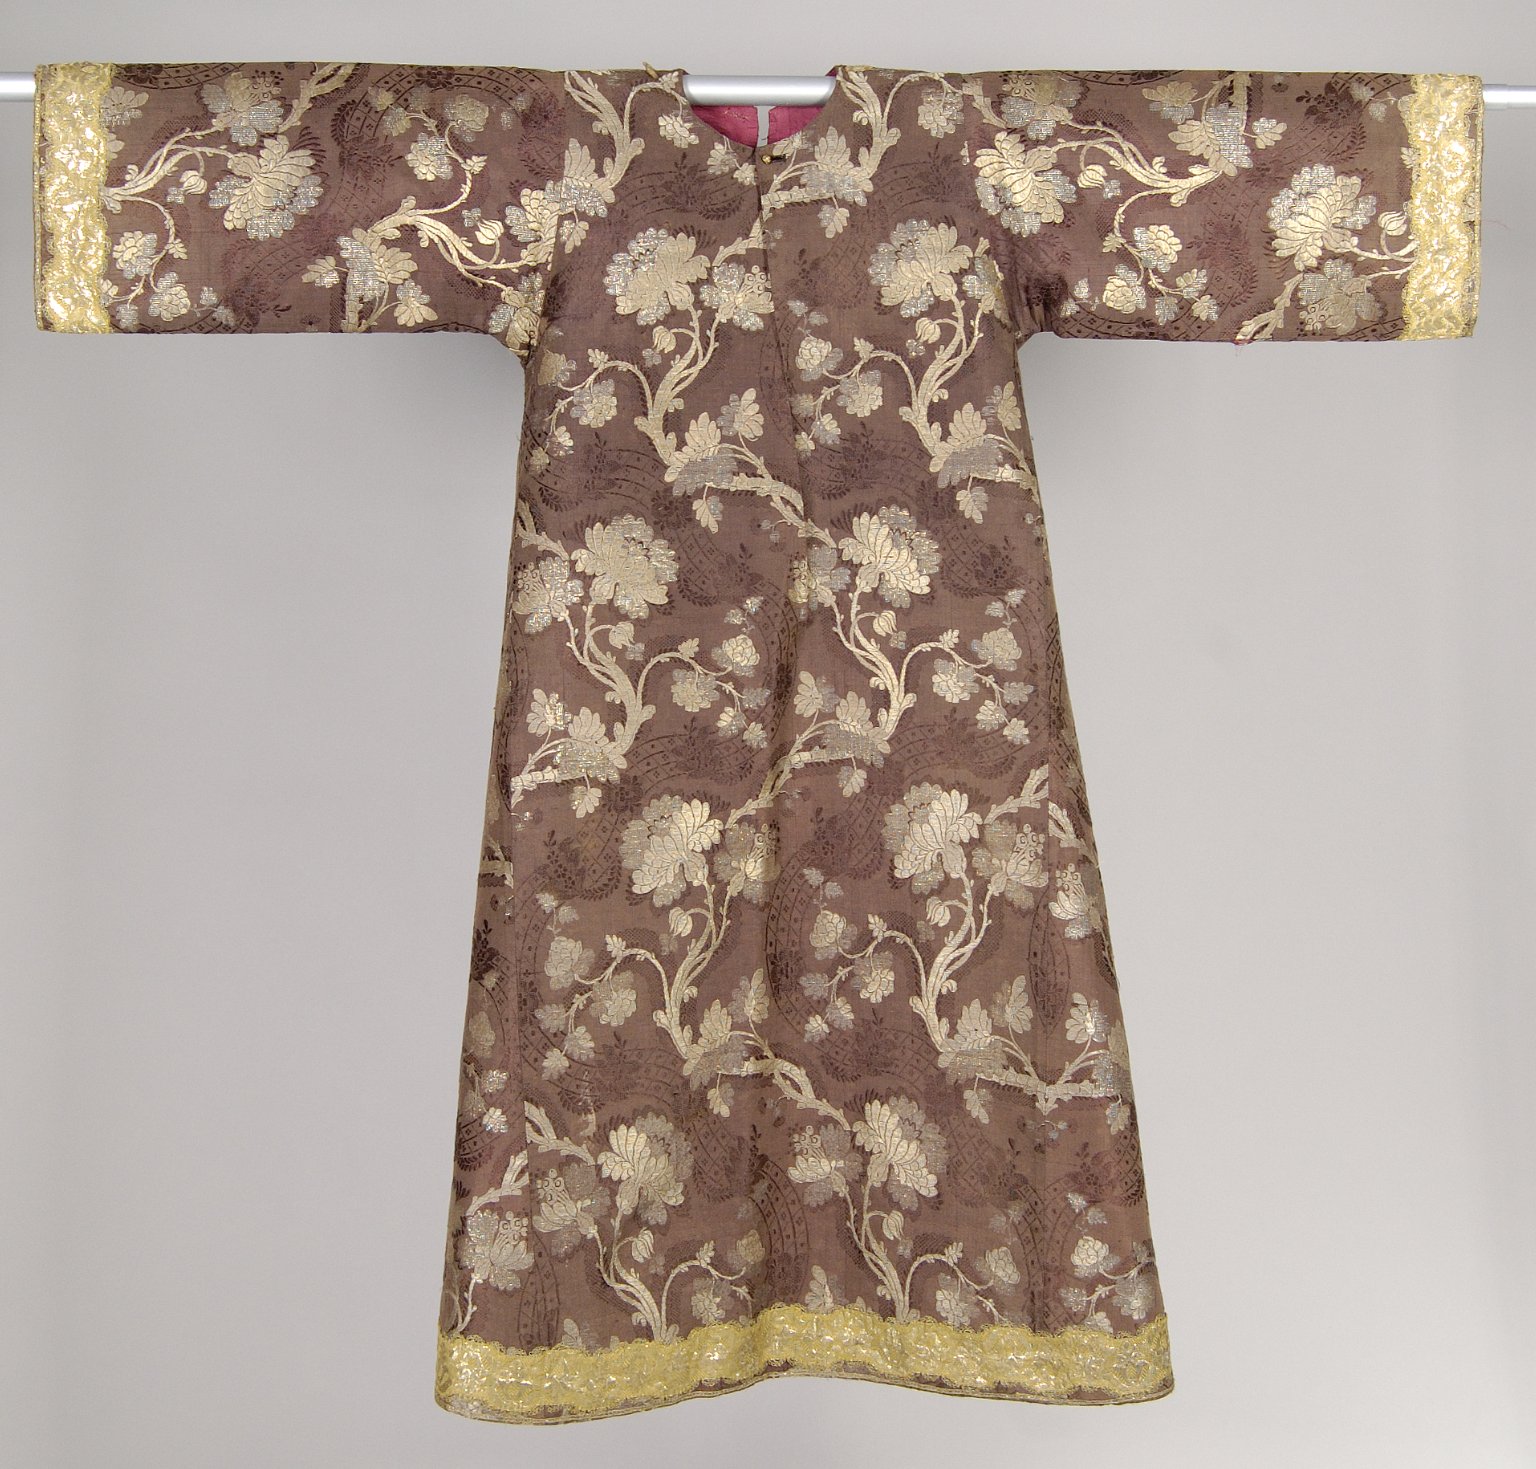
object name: dalmatic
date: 1740-1760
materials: silk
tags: flowers,leaves